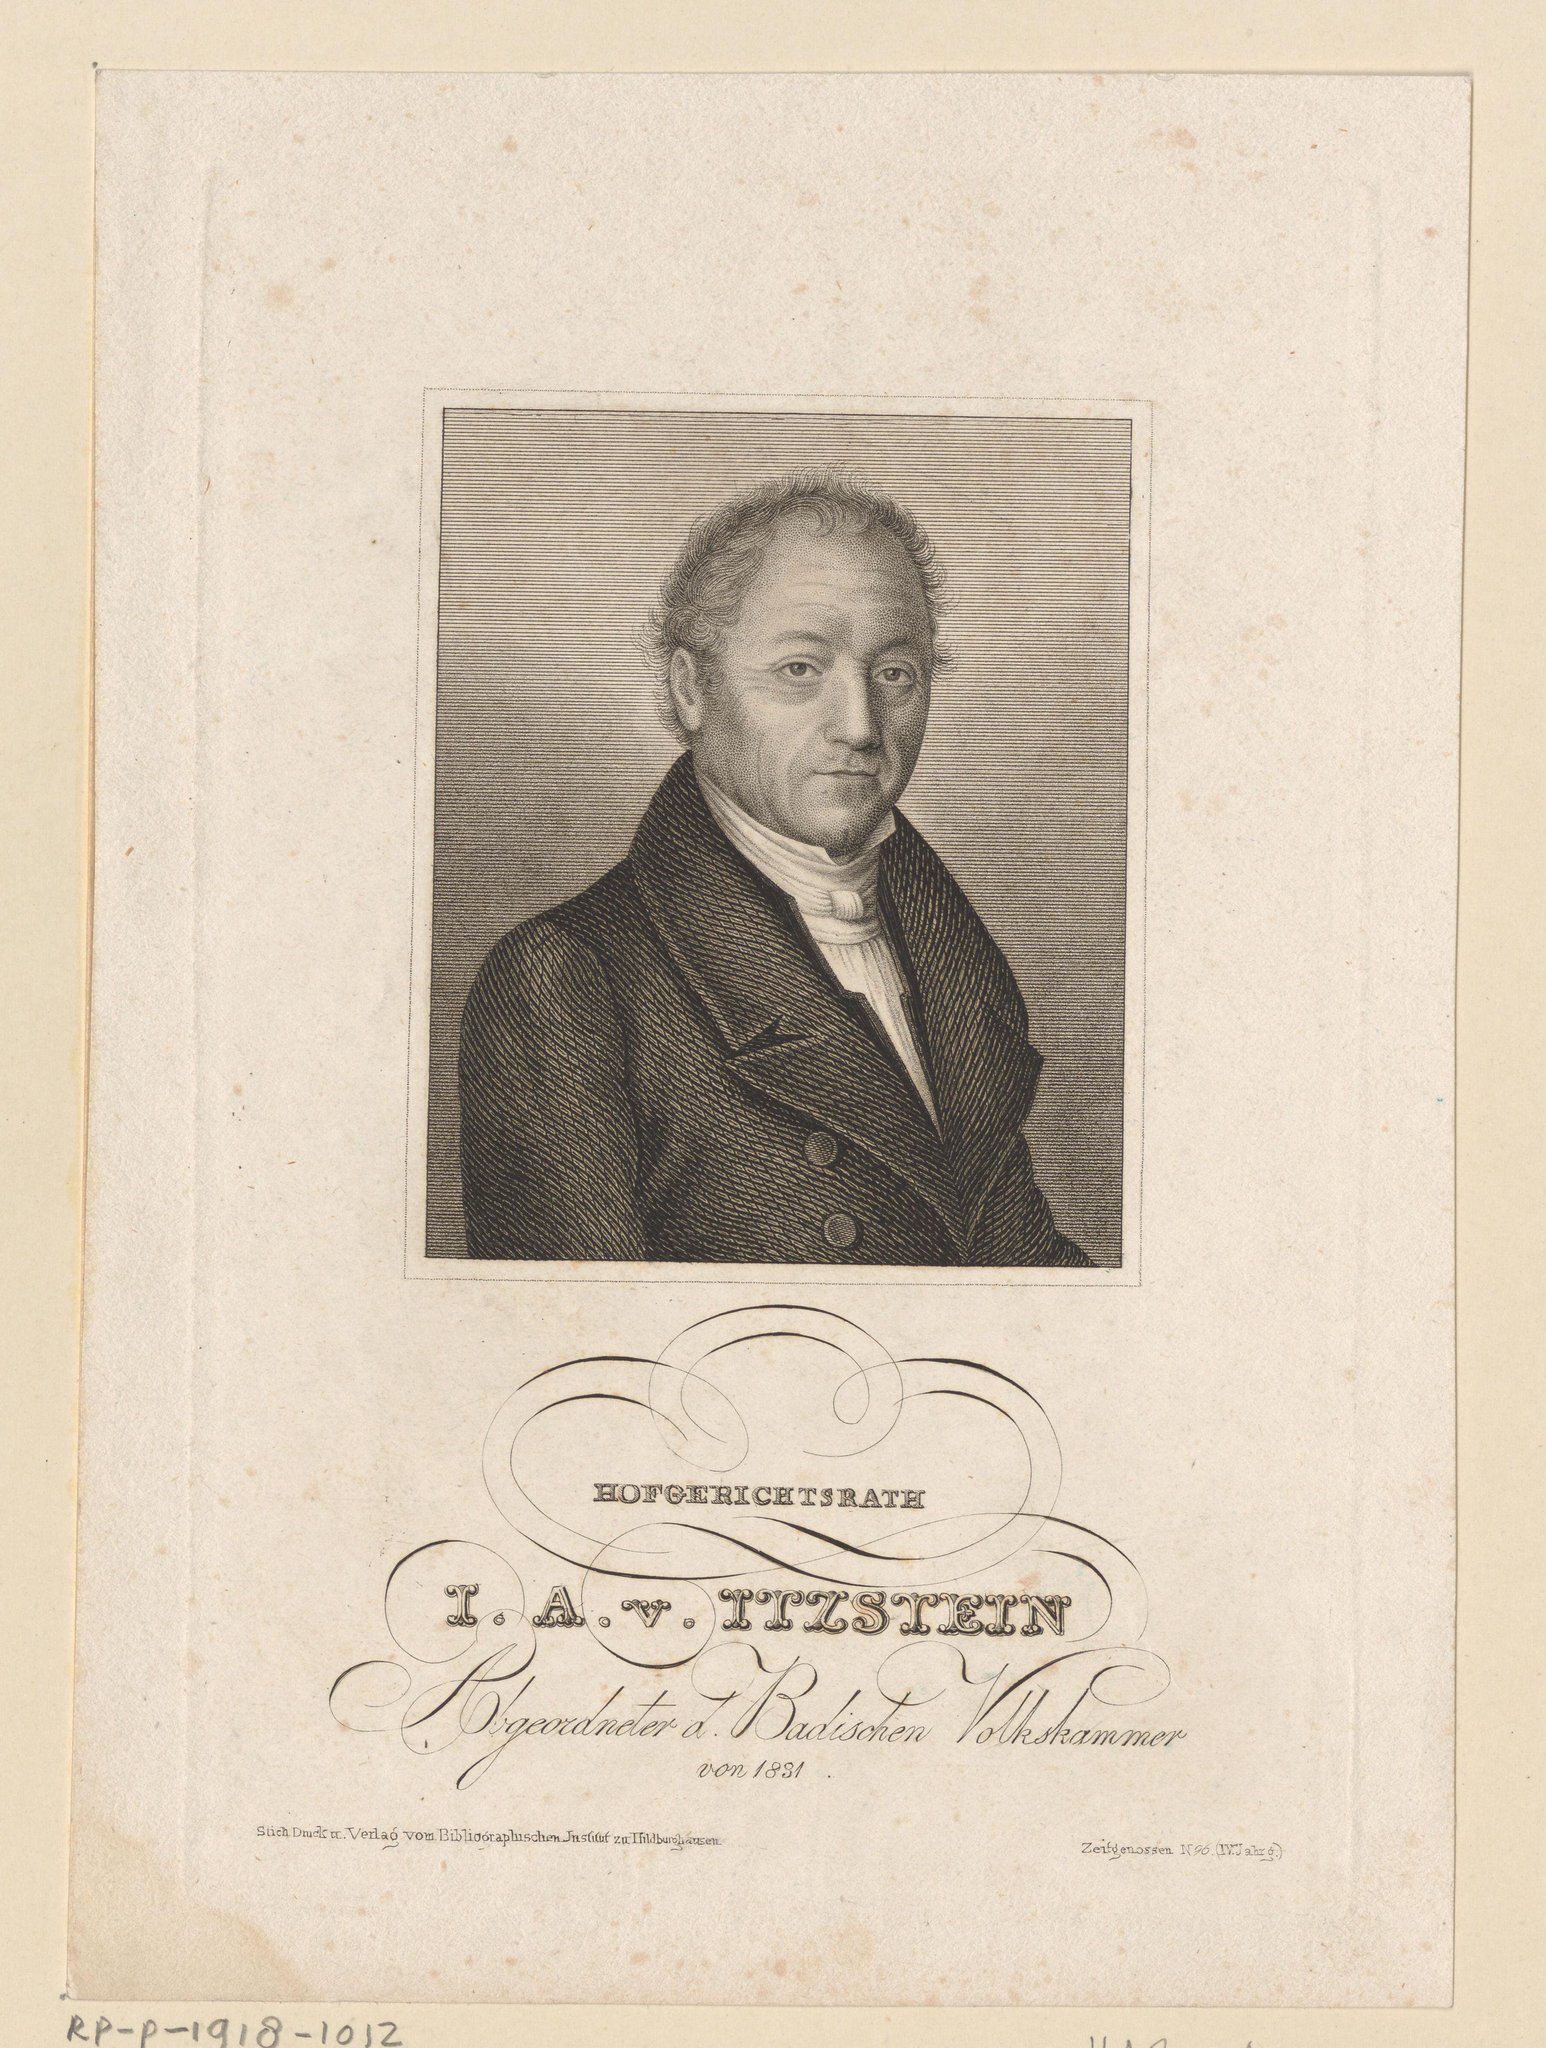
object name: print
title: Zeitgenossen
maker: johann georg nordheim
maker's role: print maker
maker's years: 1804-1853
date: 1831-1835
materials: paper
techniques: engraving, etching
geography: hildburghausen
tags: historical persons, politician, e.g. party leader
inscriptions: collector's mark: Lugt 2233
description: Deze prent maakt deel uit van de vierde jaargang van de serie 'Zeitgenossen'. Andere staat van prent gebruikt in: Meyer, Joseph. Das Grosse Conversations-Lexikon für die gebildeten Stände. Hildburghausen: Bibliographisches Institut, 1840-1855.